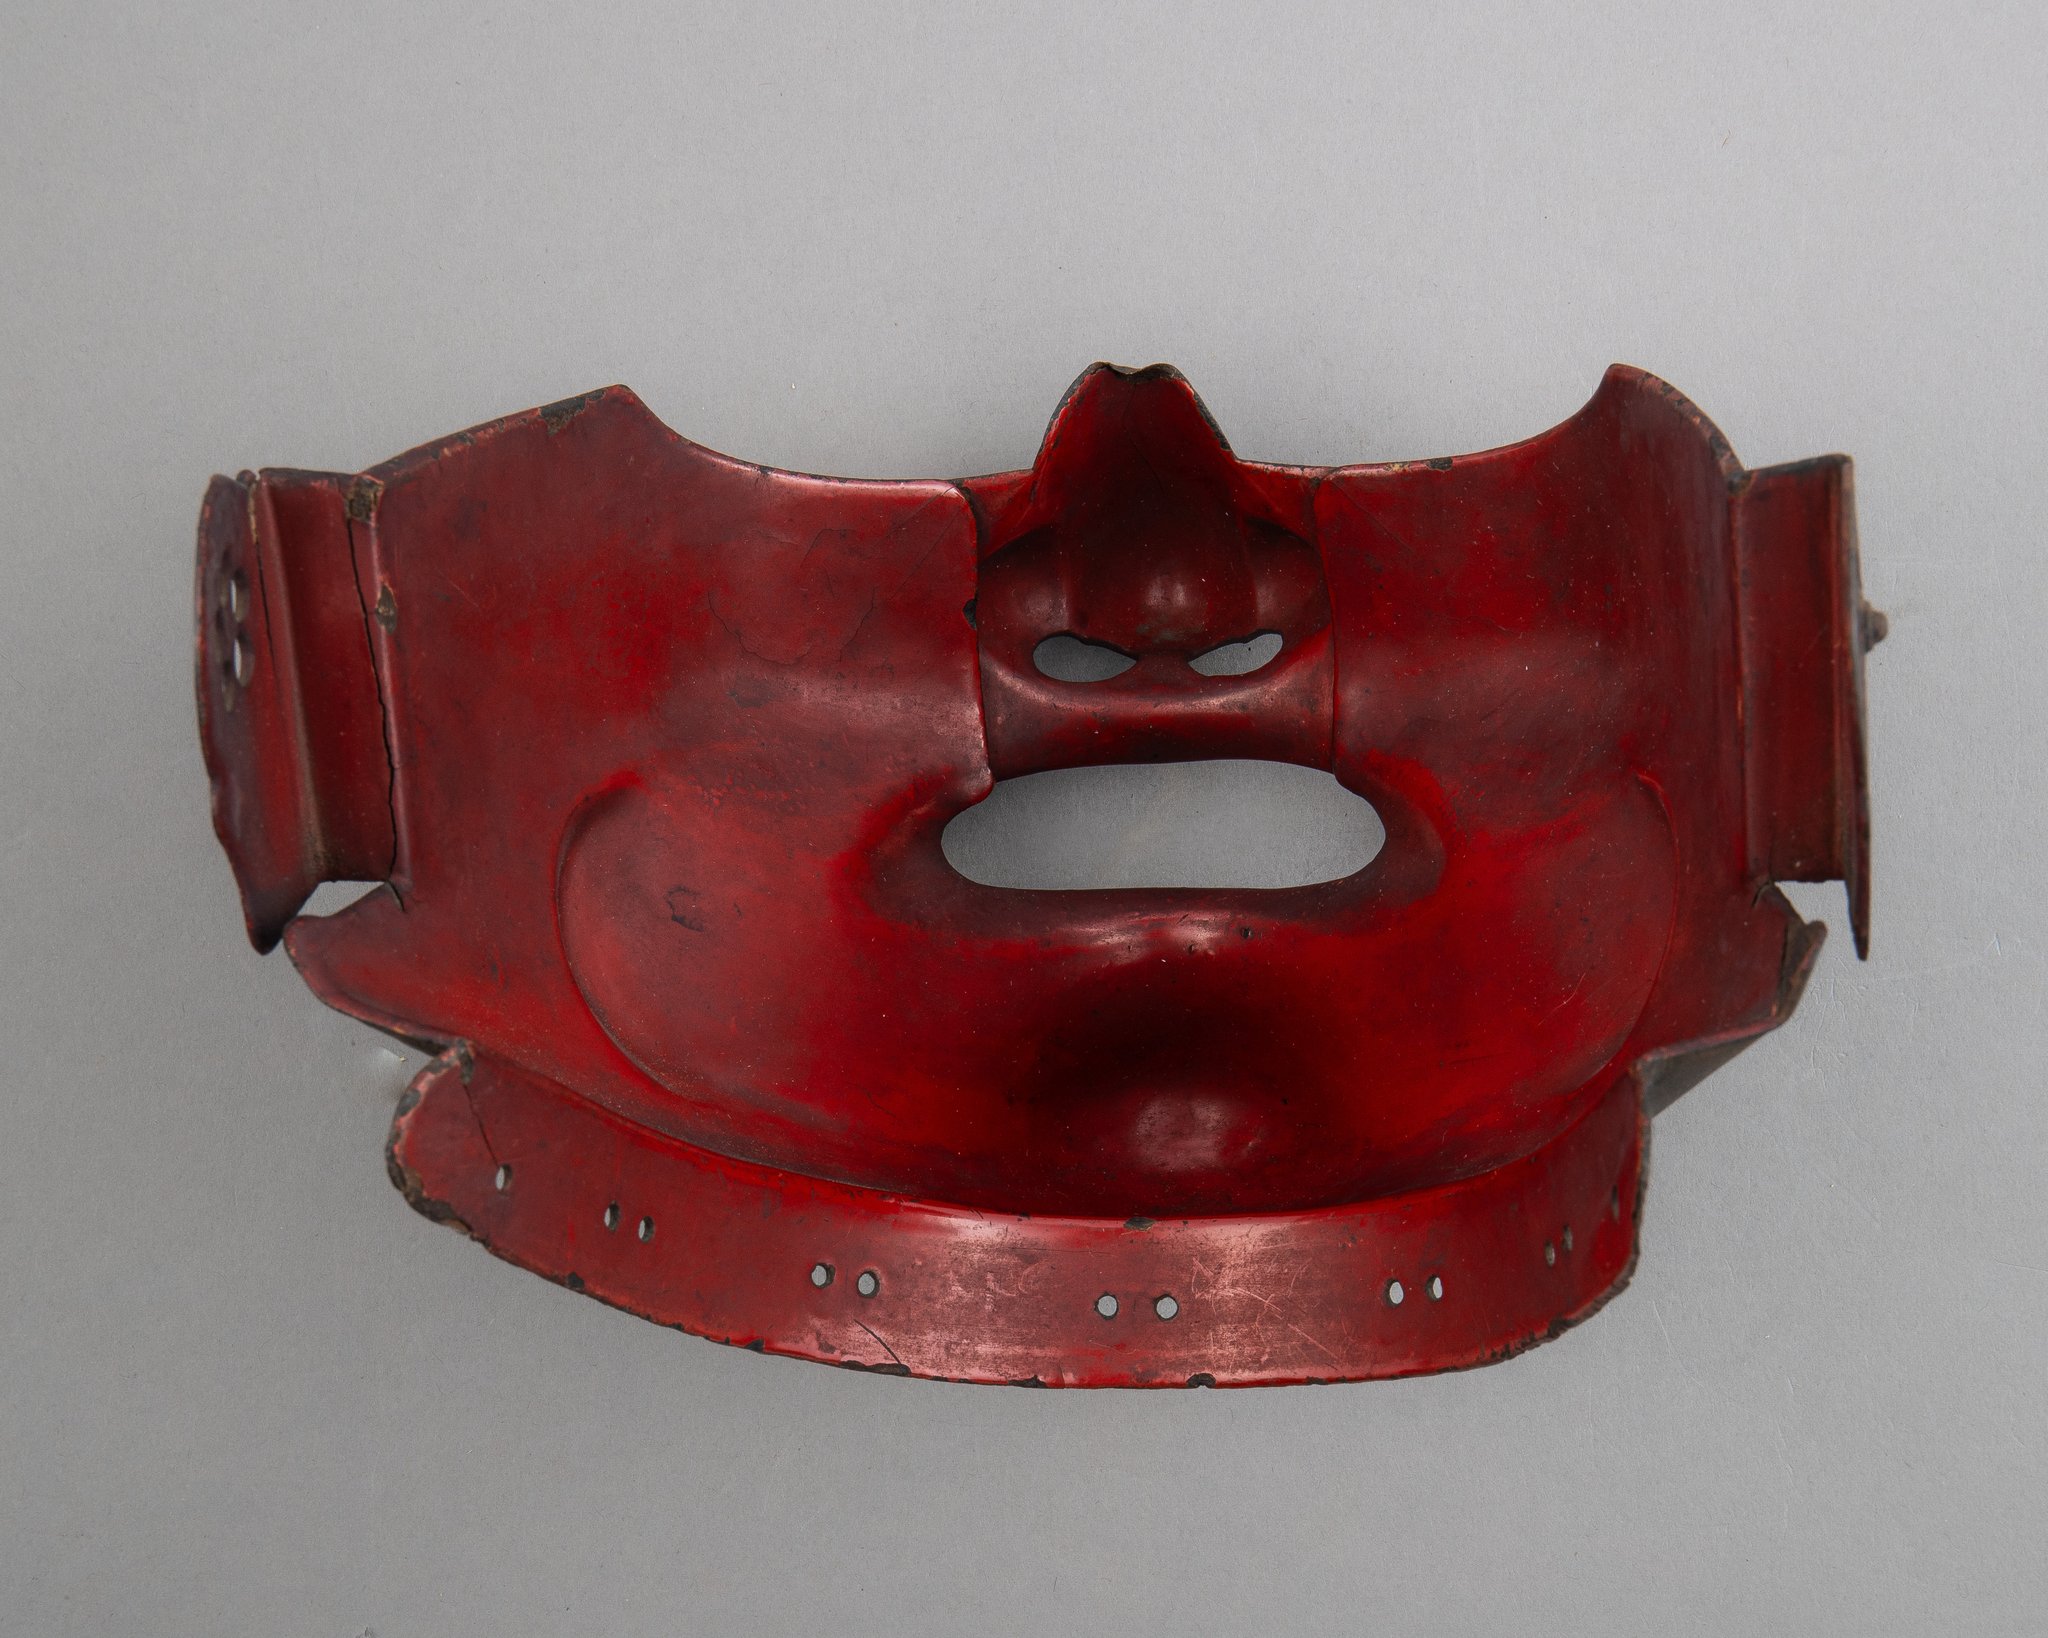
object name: half mask menpō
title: Half Mask (Menpō)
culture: japanese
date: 1615-1868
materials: iron, lacquer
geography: japan